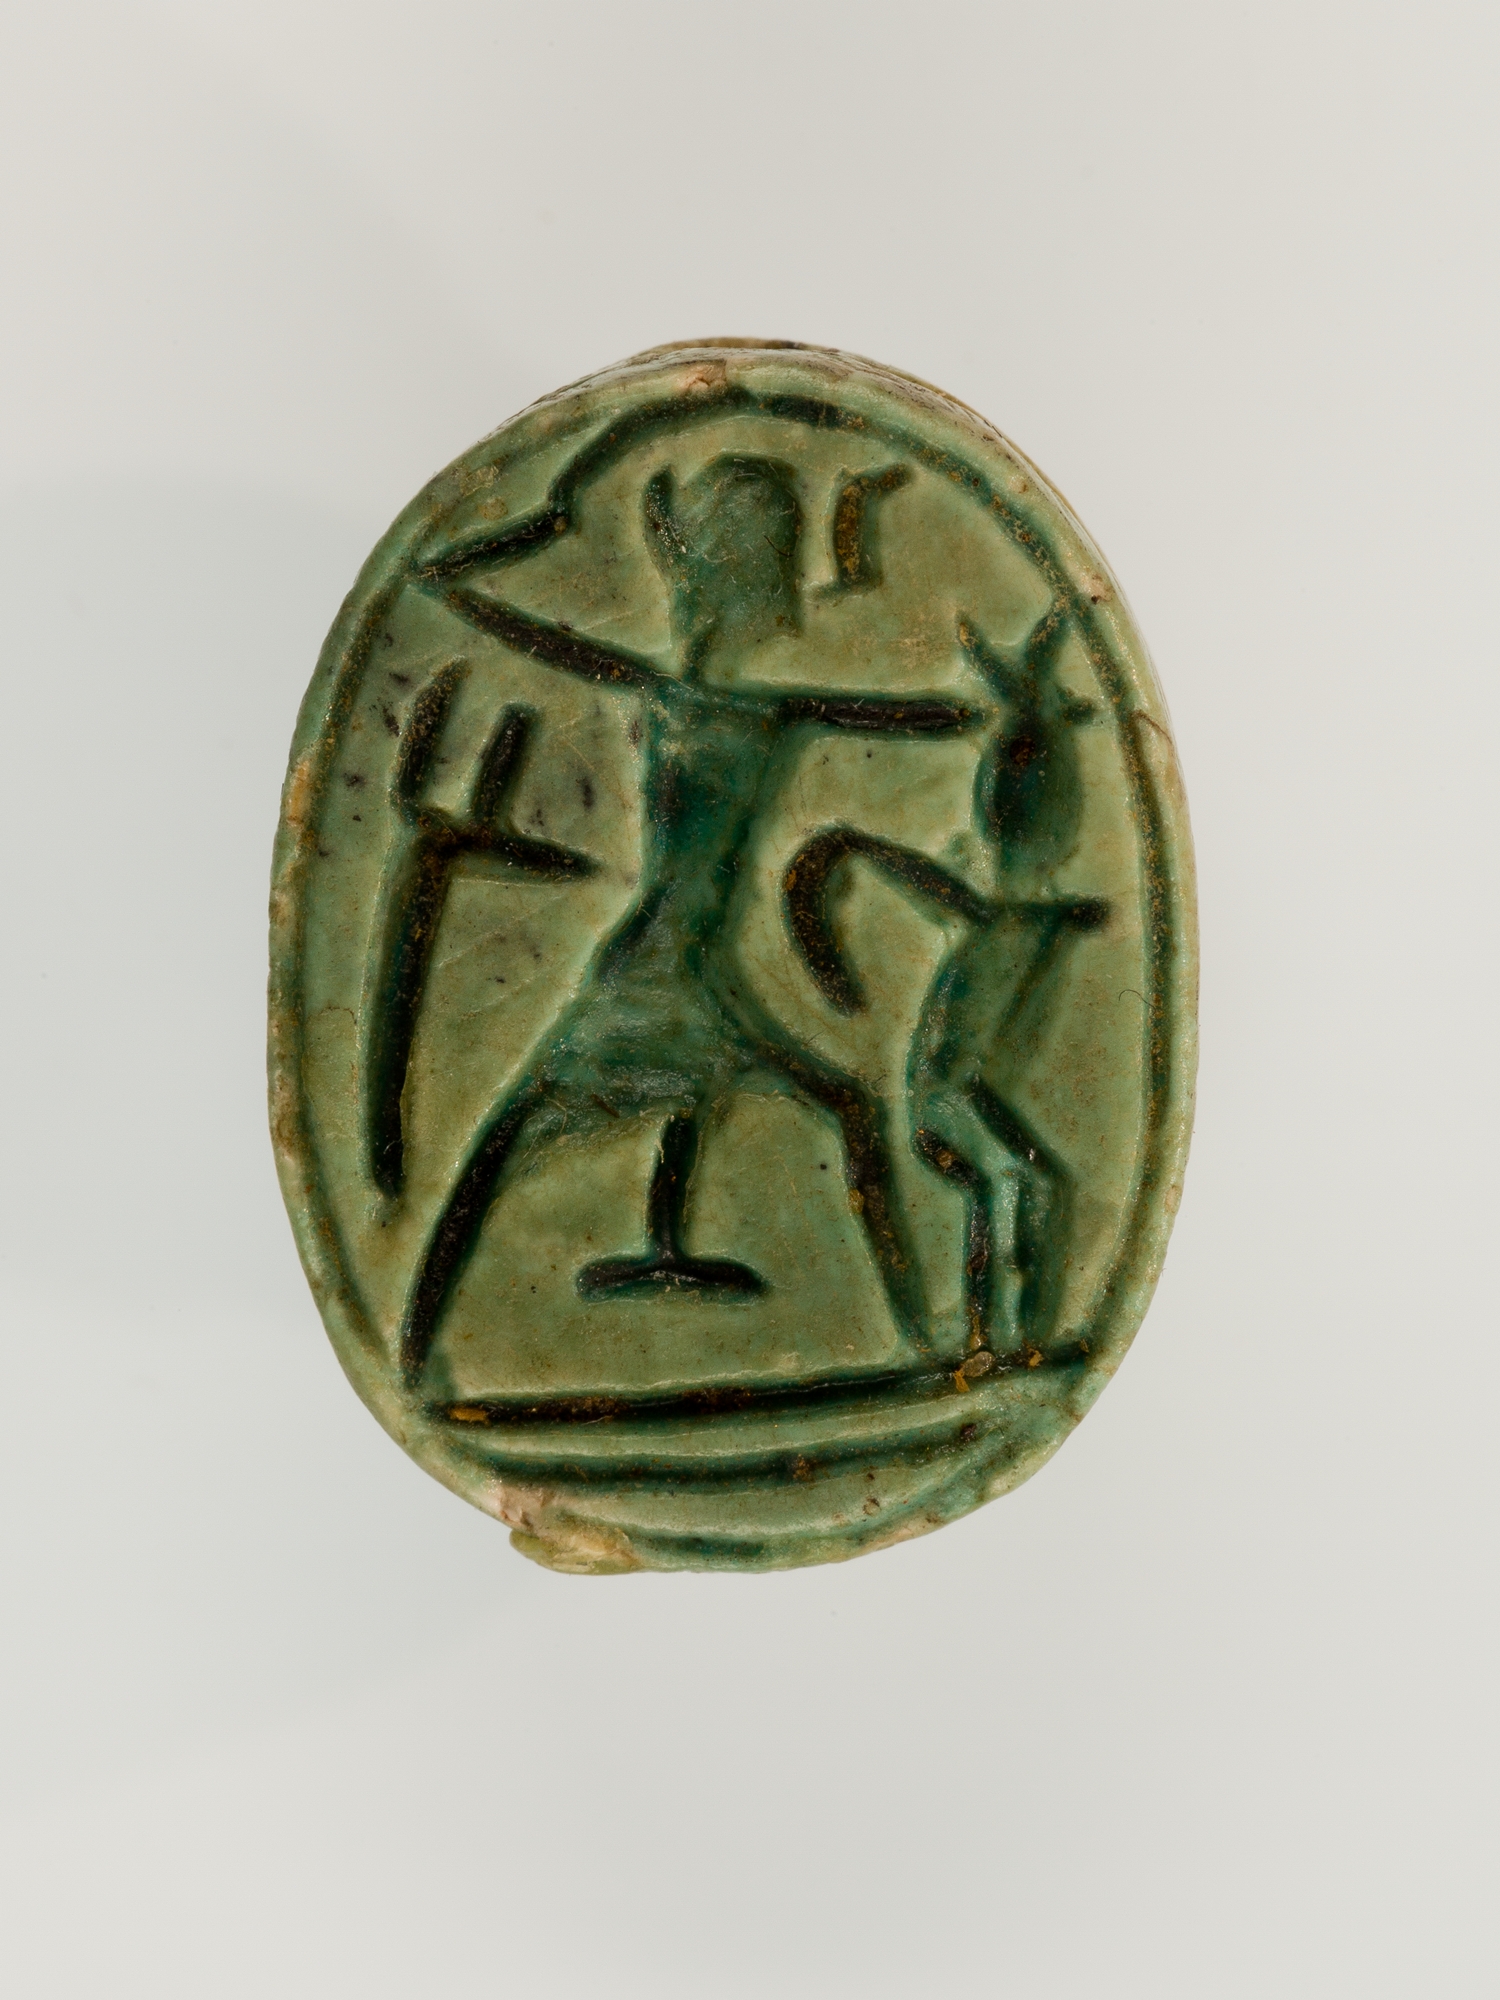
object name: scarab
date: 1295-1070 BCE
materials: stone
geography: egypt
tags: scarabs